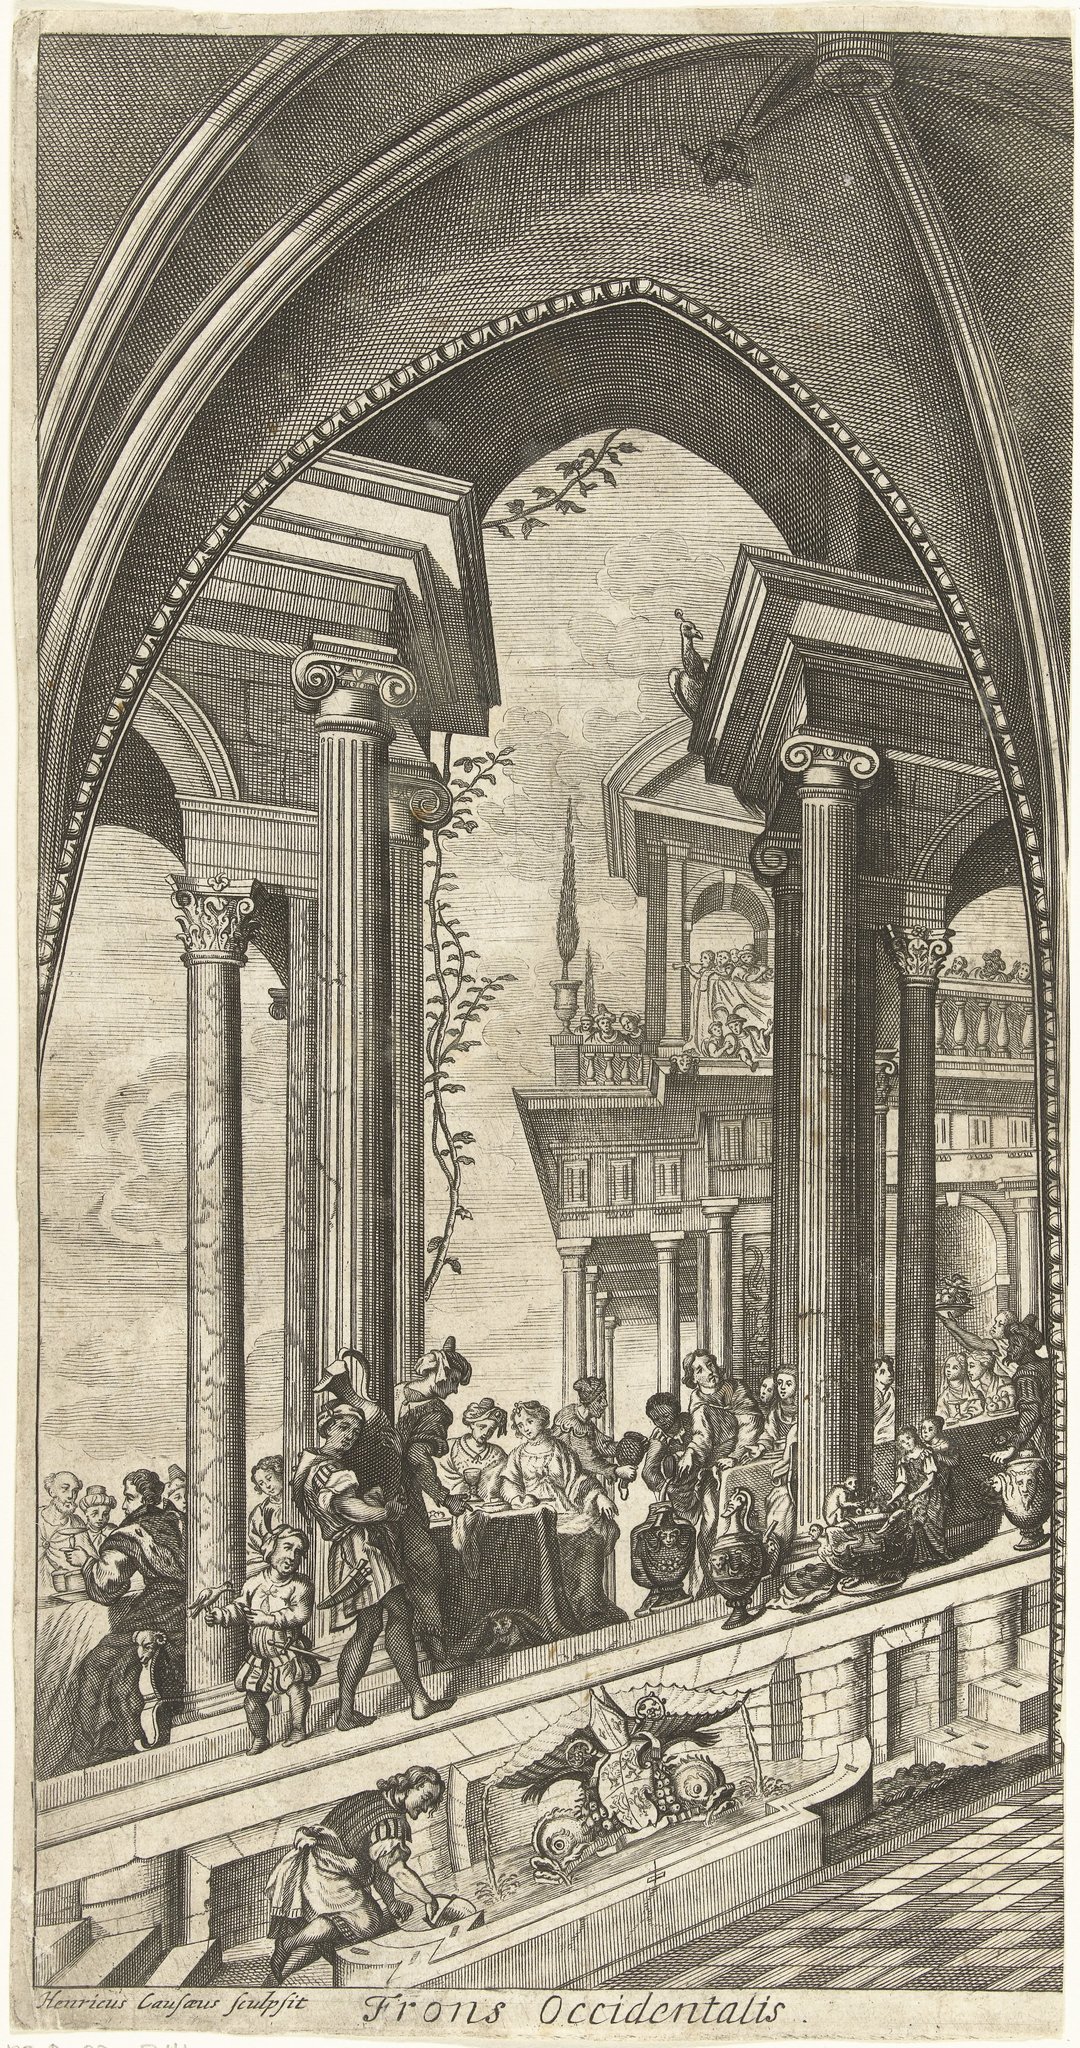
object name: print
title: Schilderingen westzijde, Sint Michielsabdij Antwerpen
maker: hendrik causé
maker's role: print maker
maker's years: 1648-1699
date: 1699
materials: paper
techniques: engraving, etching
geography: antwerp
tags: interior of church, celebration meal, feast, banquet, the marriage-feast at cana (john 2:1-11), antwerp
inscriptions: collector's mark: Lugt 2228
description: Gezicht op de schilderingen aan de westzijde van de kerk van de Sint Michielsabdij te Antwerpen. Christus bij de bruiloft te Kana. Hij laat zes kruiken met water vullen en verandert het water in wijn.